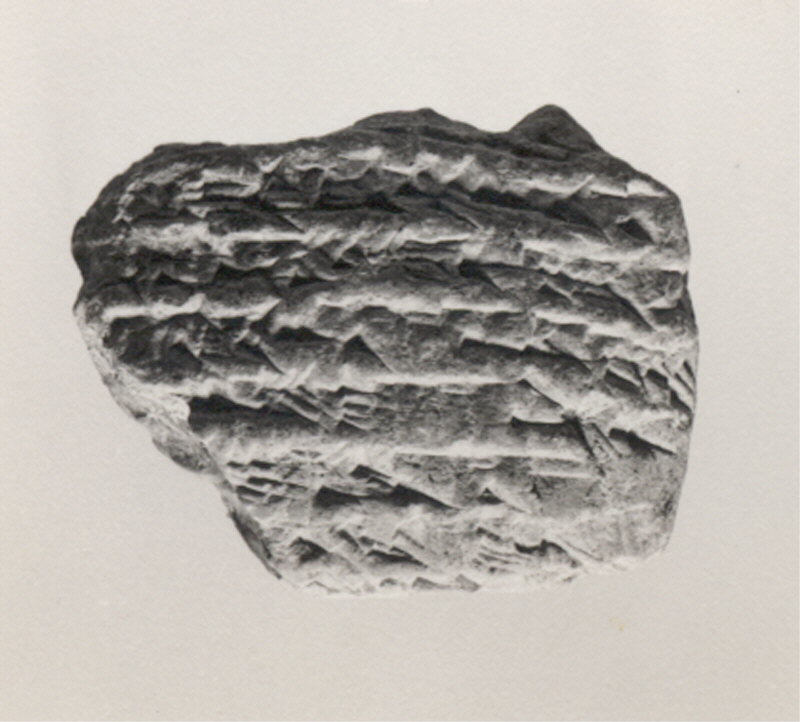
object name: cuneiform tablet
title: Cuneiform tablet: receipt for silver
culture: achaemenid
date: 539-331 BCE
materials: clay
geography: mesopotamia